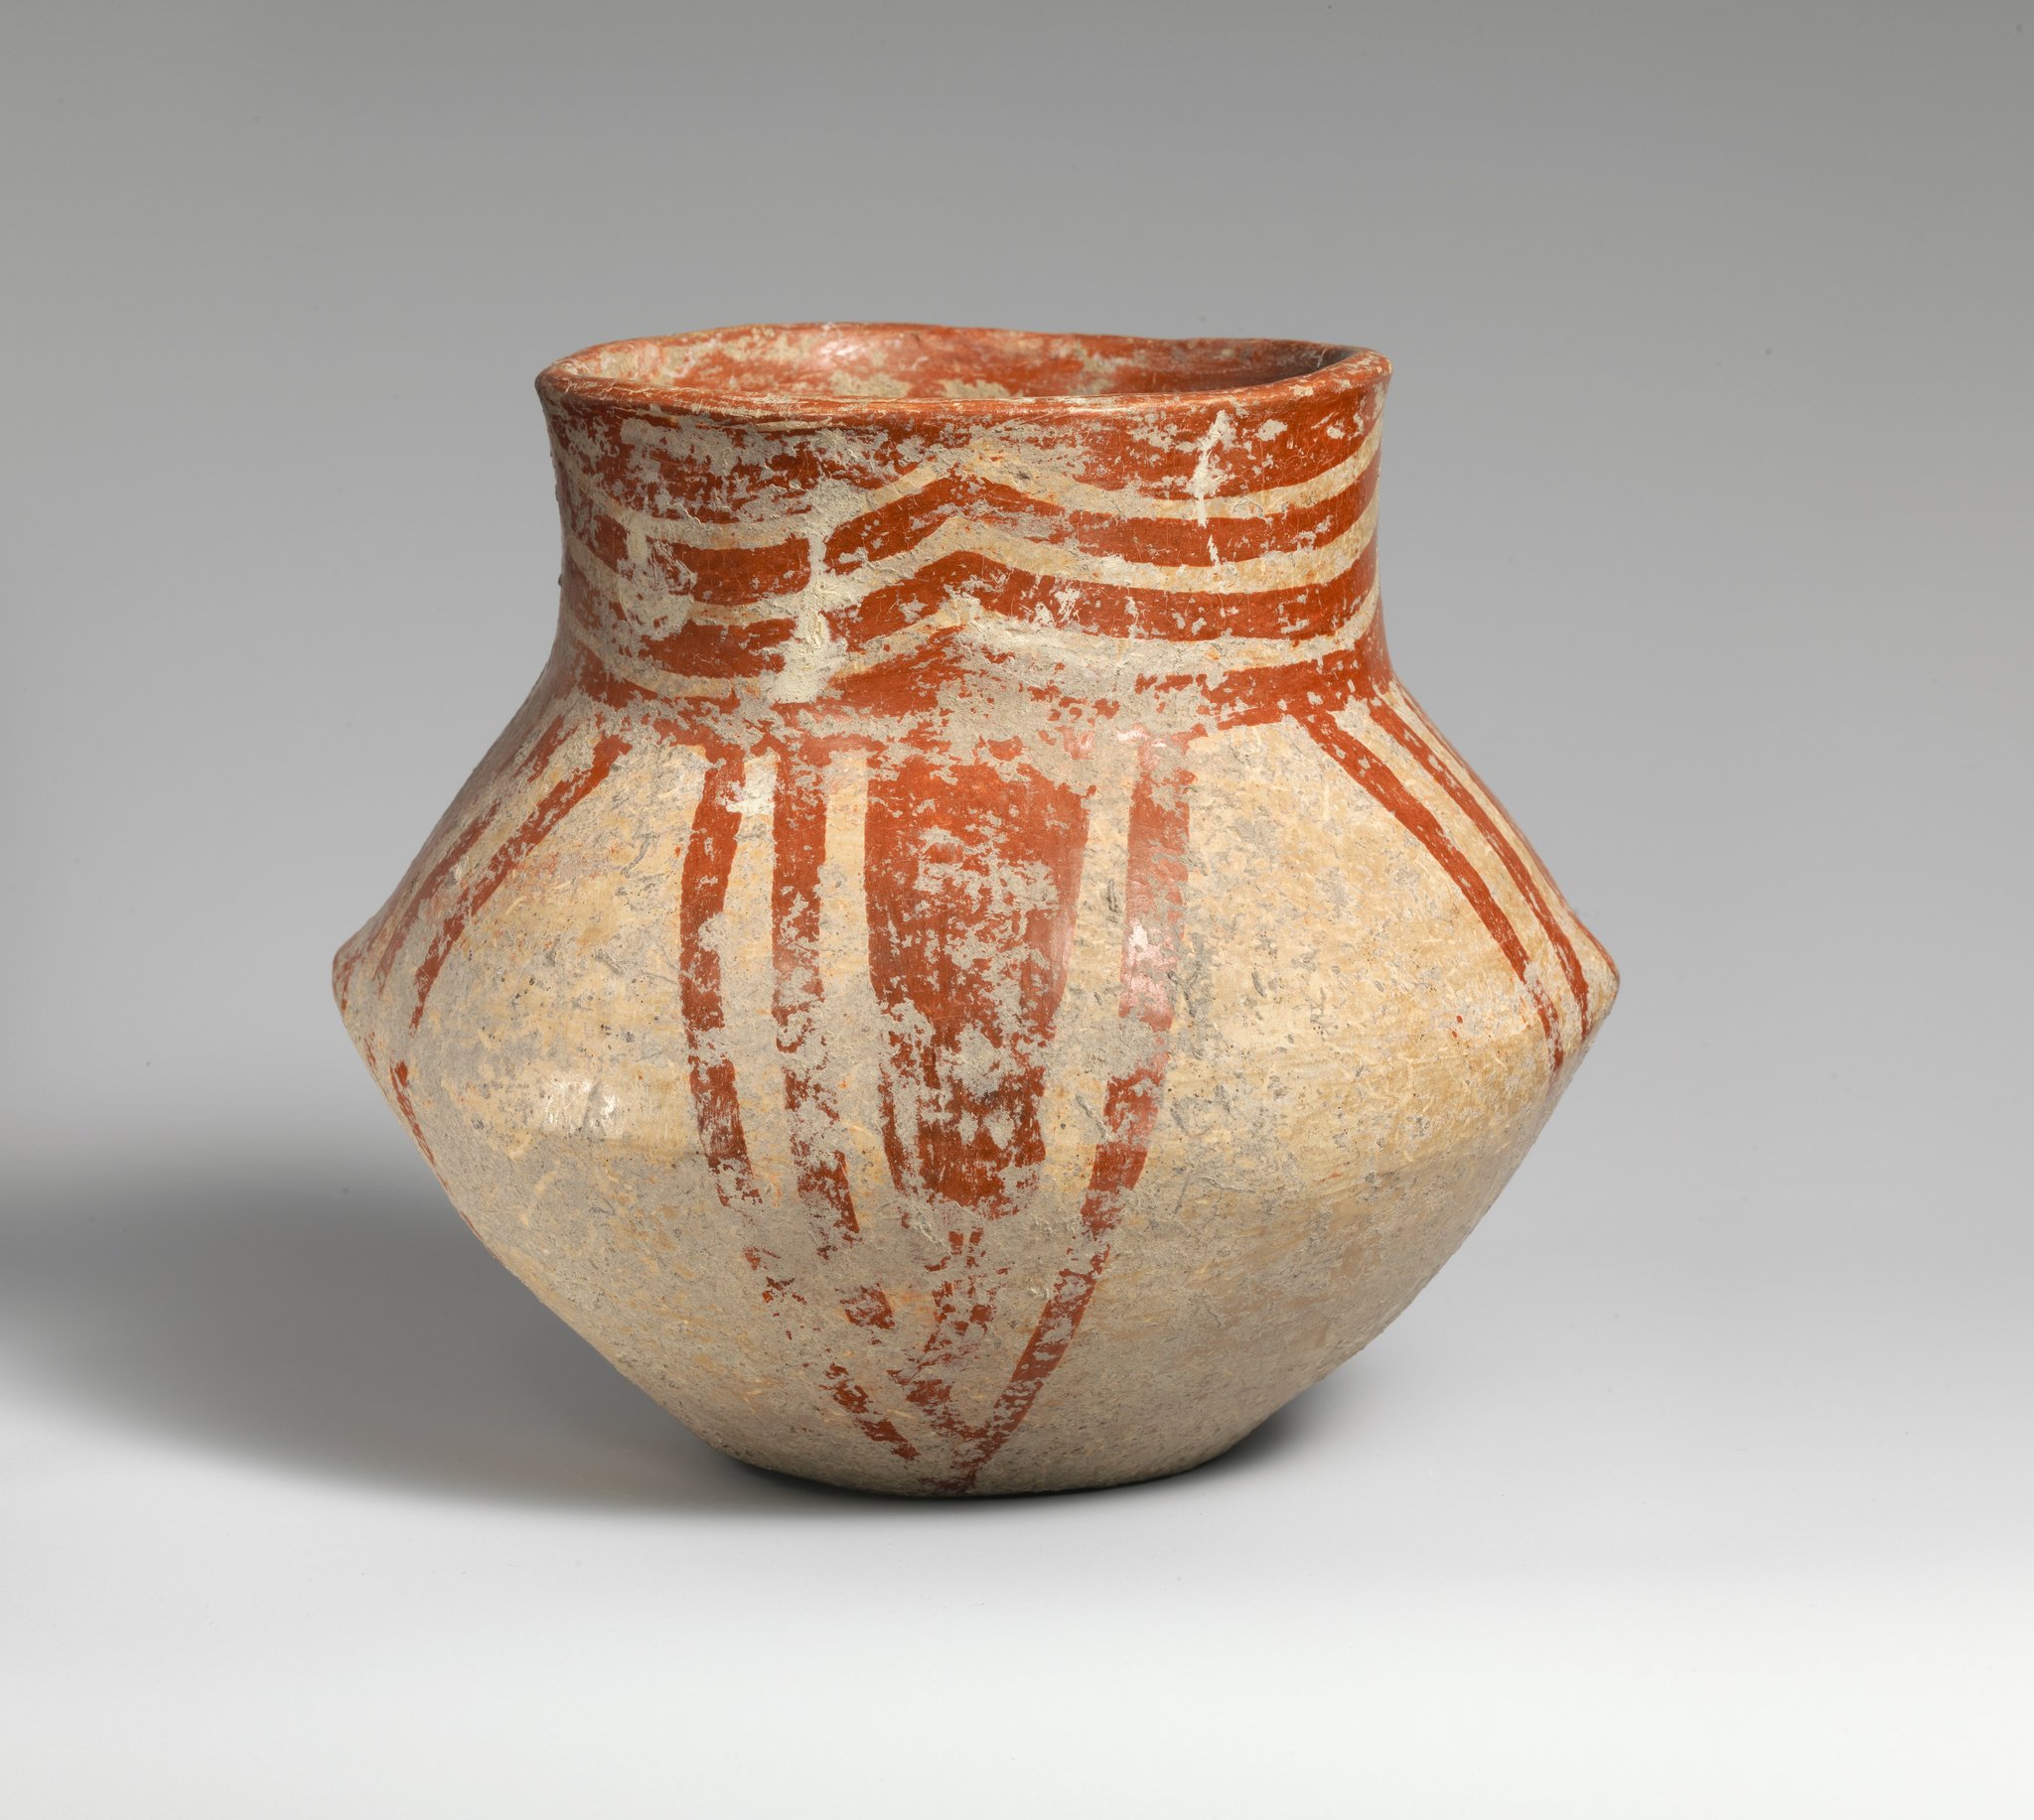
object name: jar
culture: hacilar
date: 5600-5400 BCE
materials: ceramic, paint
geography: southwestern anatolia